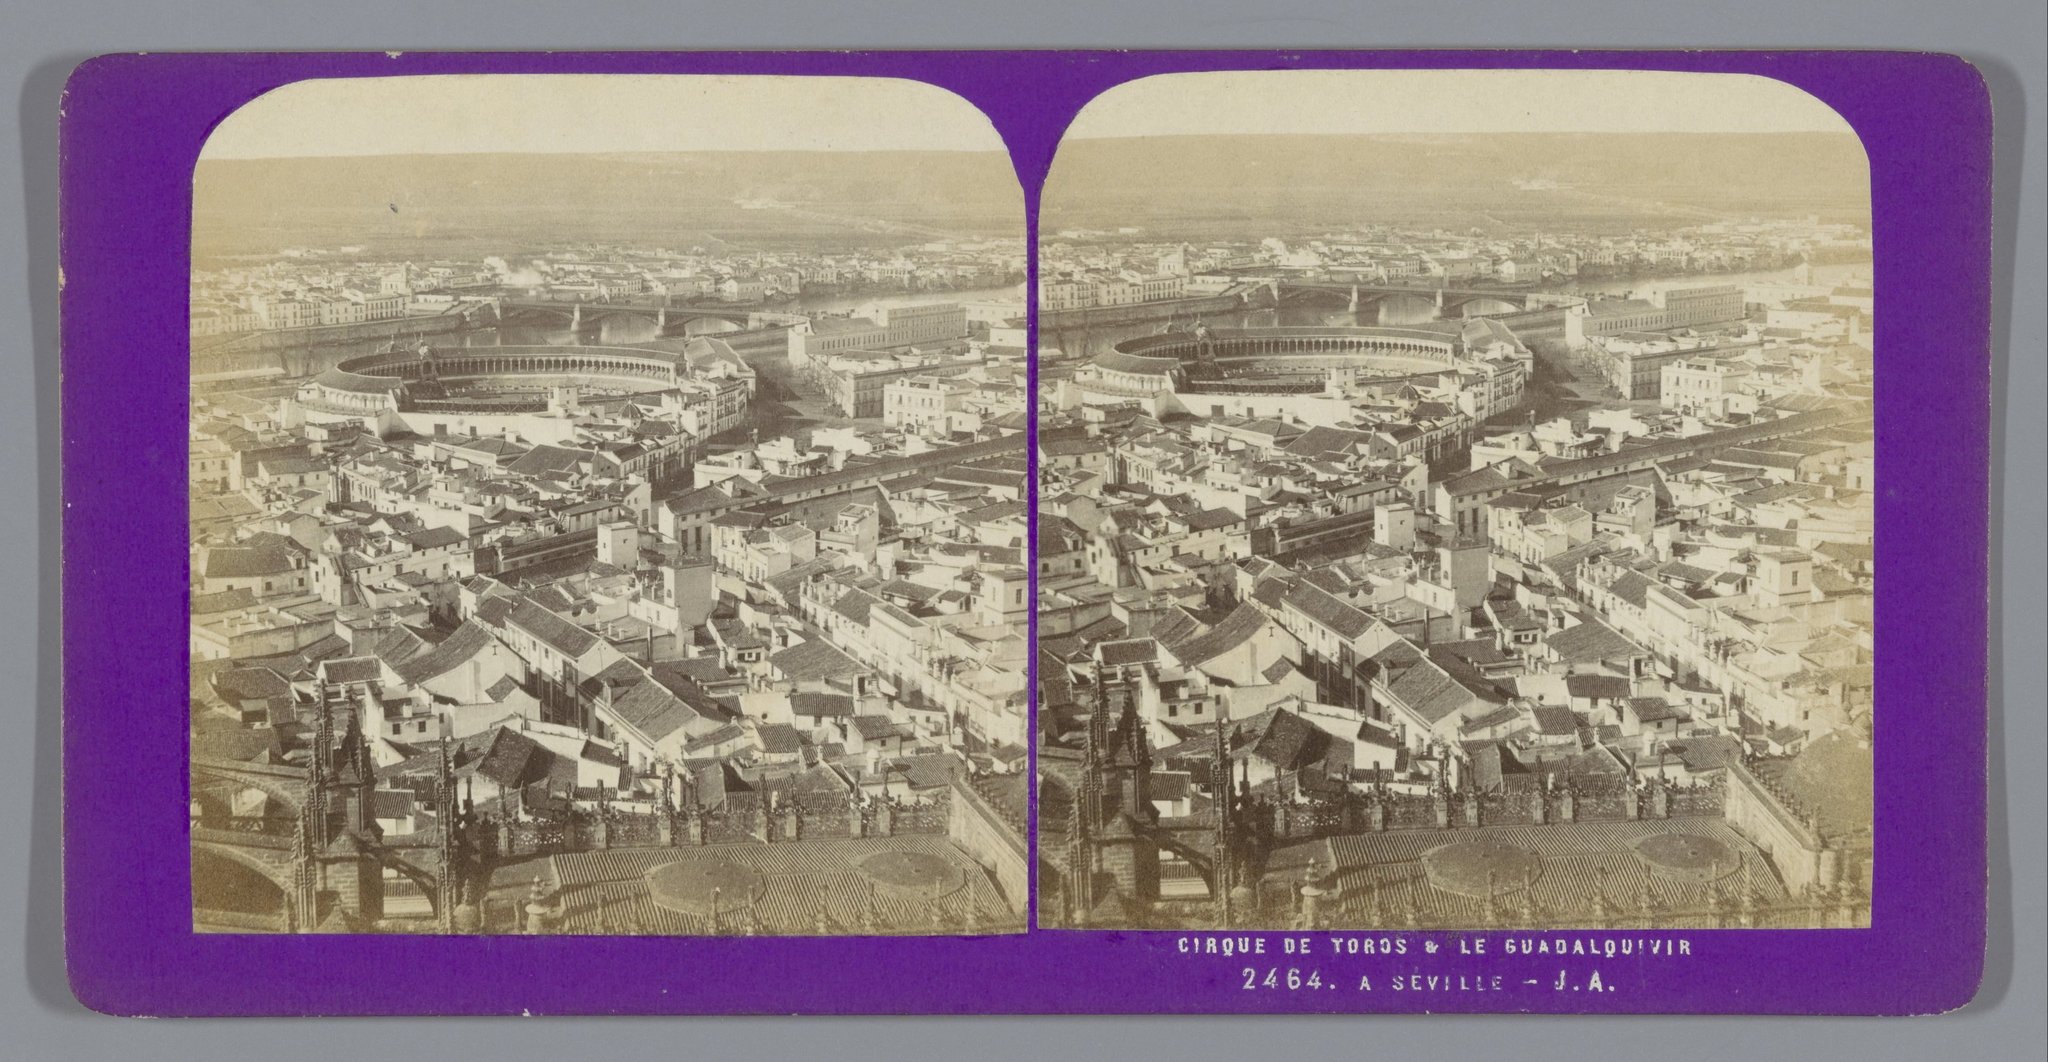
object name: stereograph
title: Gezicht op Sevilla met het Plaza de Toros en de Guadalquivir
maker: jean andrieu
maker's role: fotograaf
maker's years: 1816-1872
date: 1862-1876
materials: cardboard, photographic support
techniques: albumen print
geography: sevilla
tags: prospect of city, town panorama, silhouette of city, circus ring, sevilla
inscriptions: number: ‘2464.’